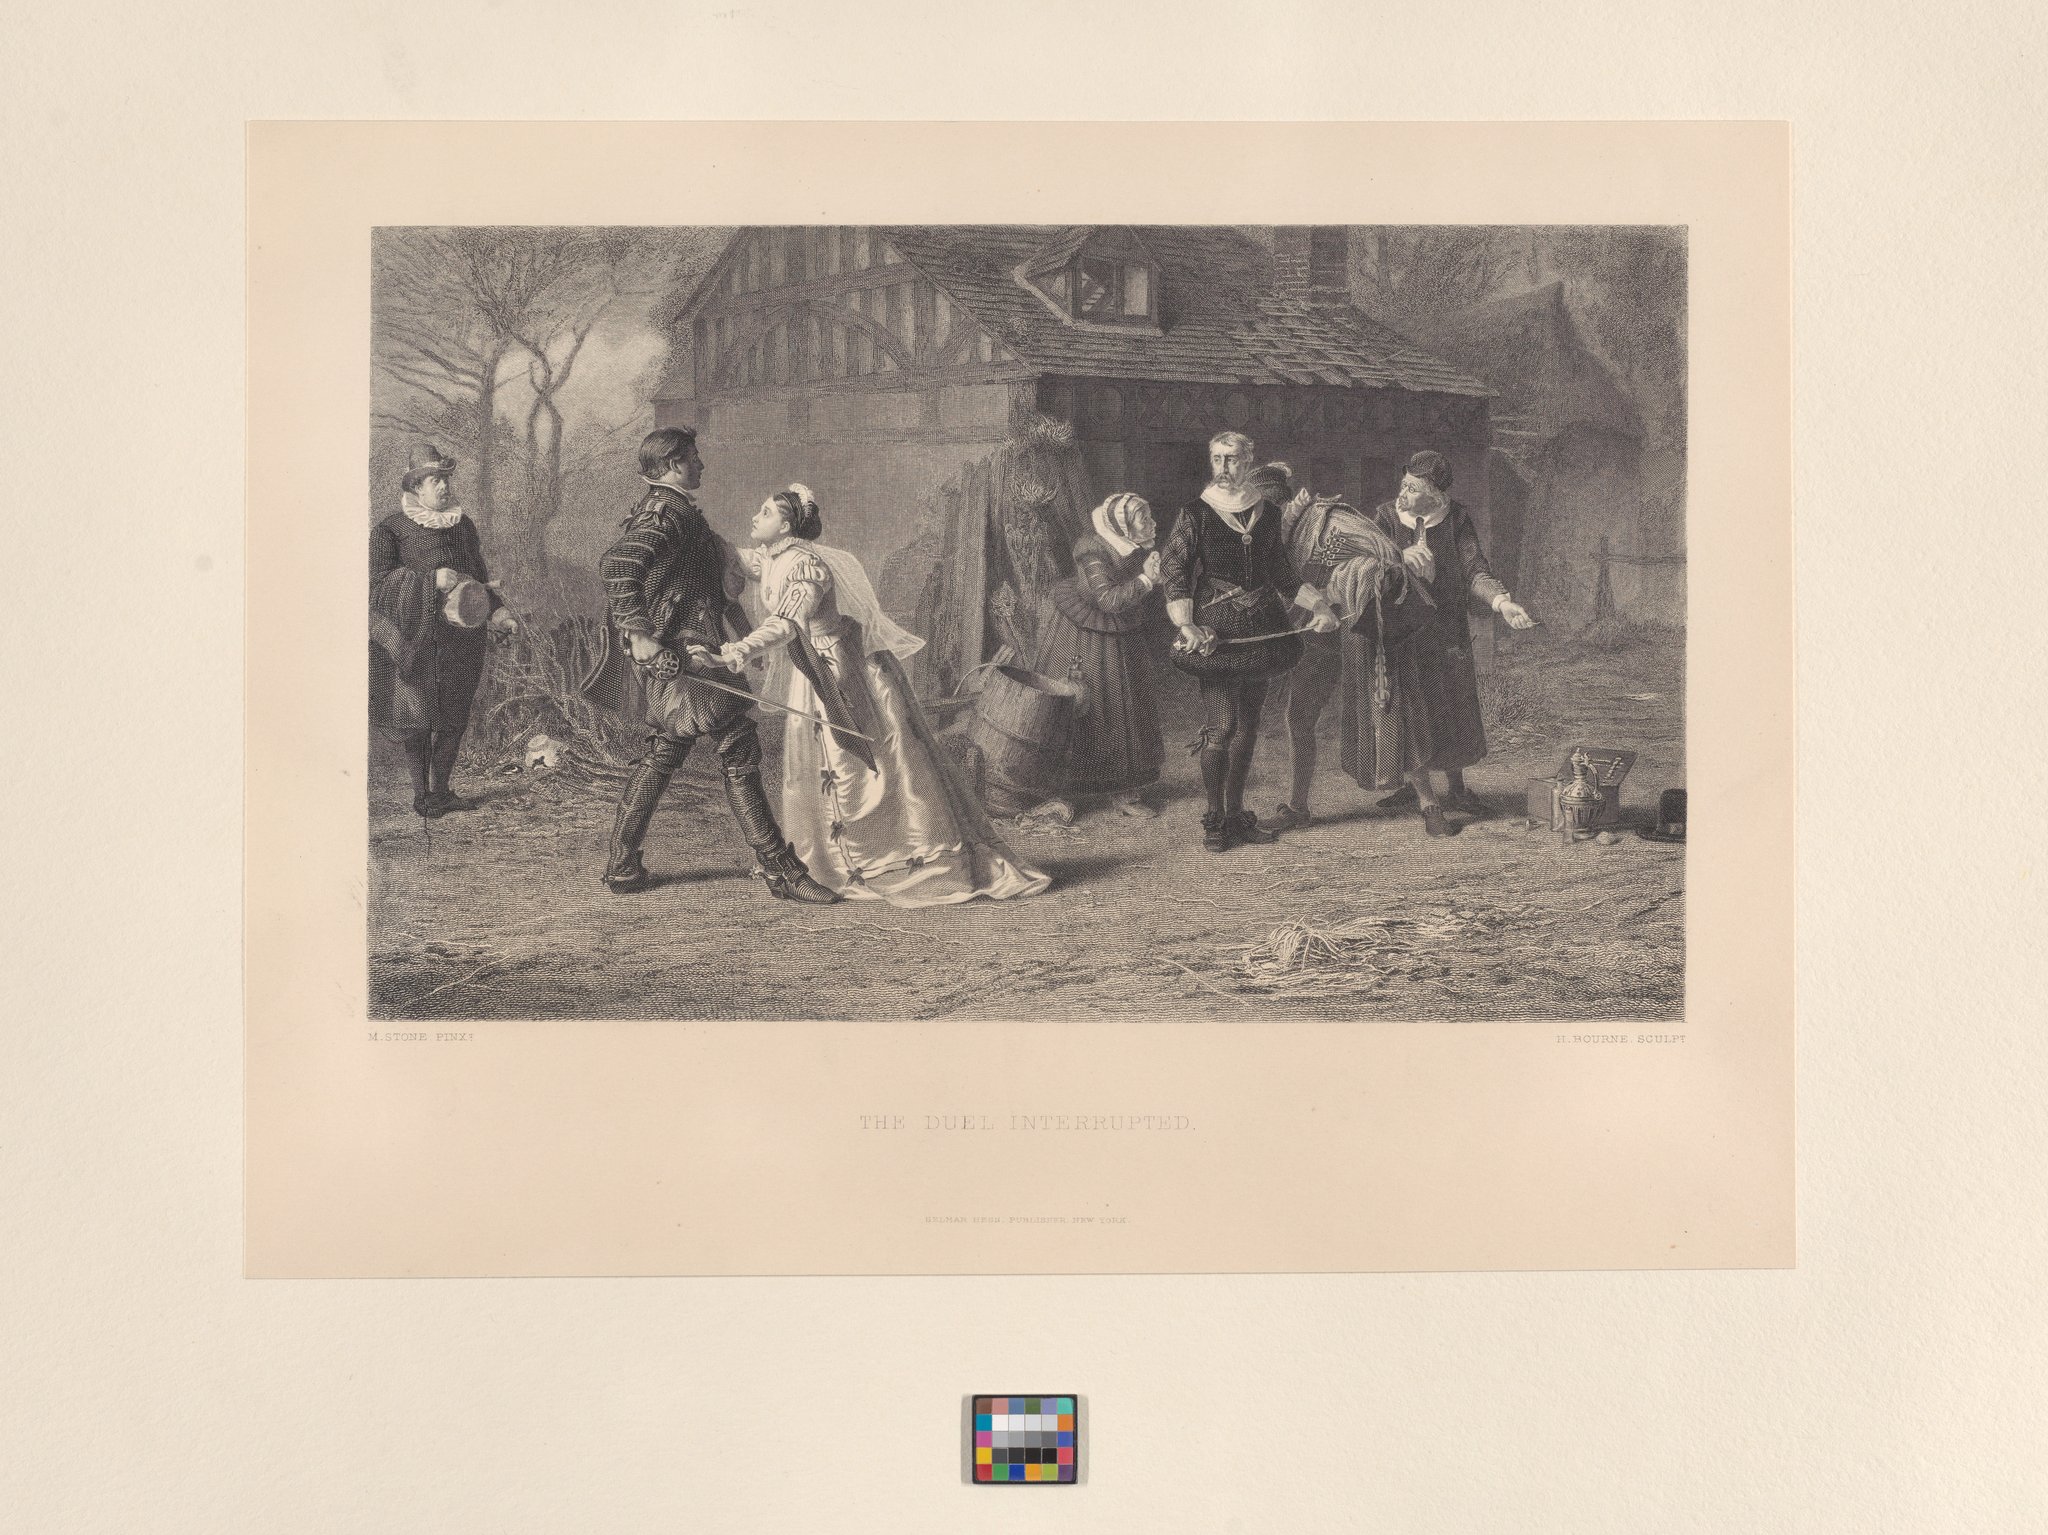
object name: print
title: The Duel Interrupted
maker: herbert bourne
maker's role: engraver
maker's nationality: british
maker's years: 1820-1907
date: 1871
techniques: engraving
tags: swords,men,women